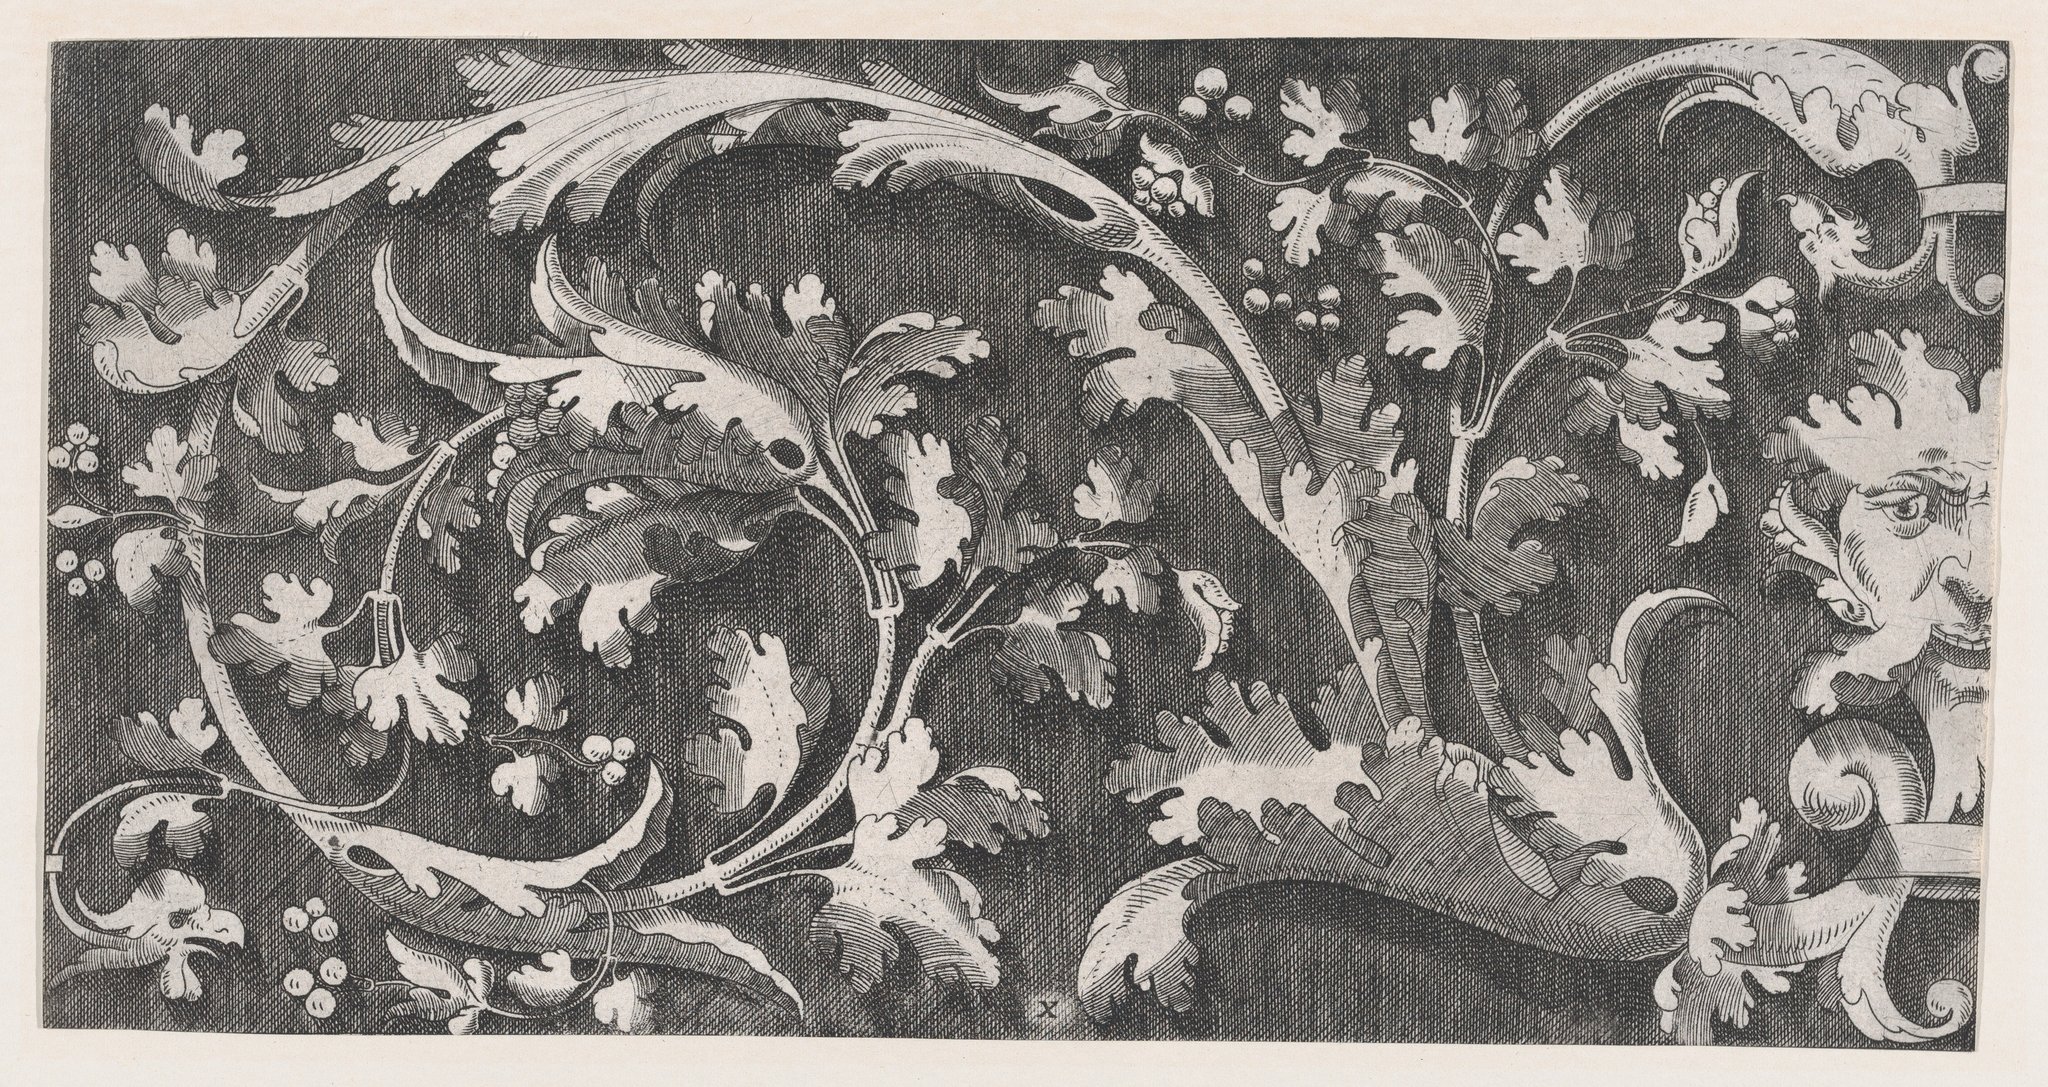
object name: print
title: Ornamental Foliage with the Left Half of a Mask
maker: anonymous, italian, 16th century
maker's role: artist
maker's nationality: italian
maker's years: 1500-1600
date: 1534-1566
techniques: engraving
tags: masks,leaves